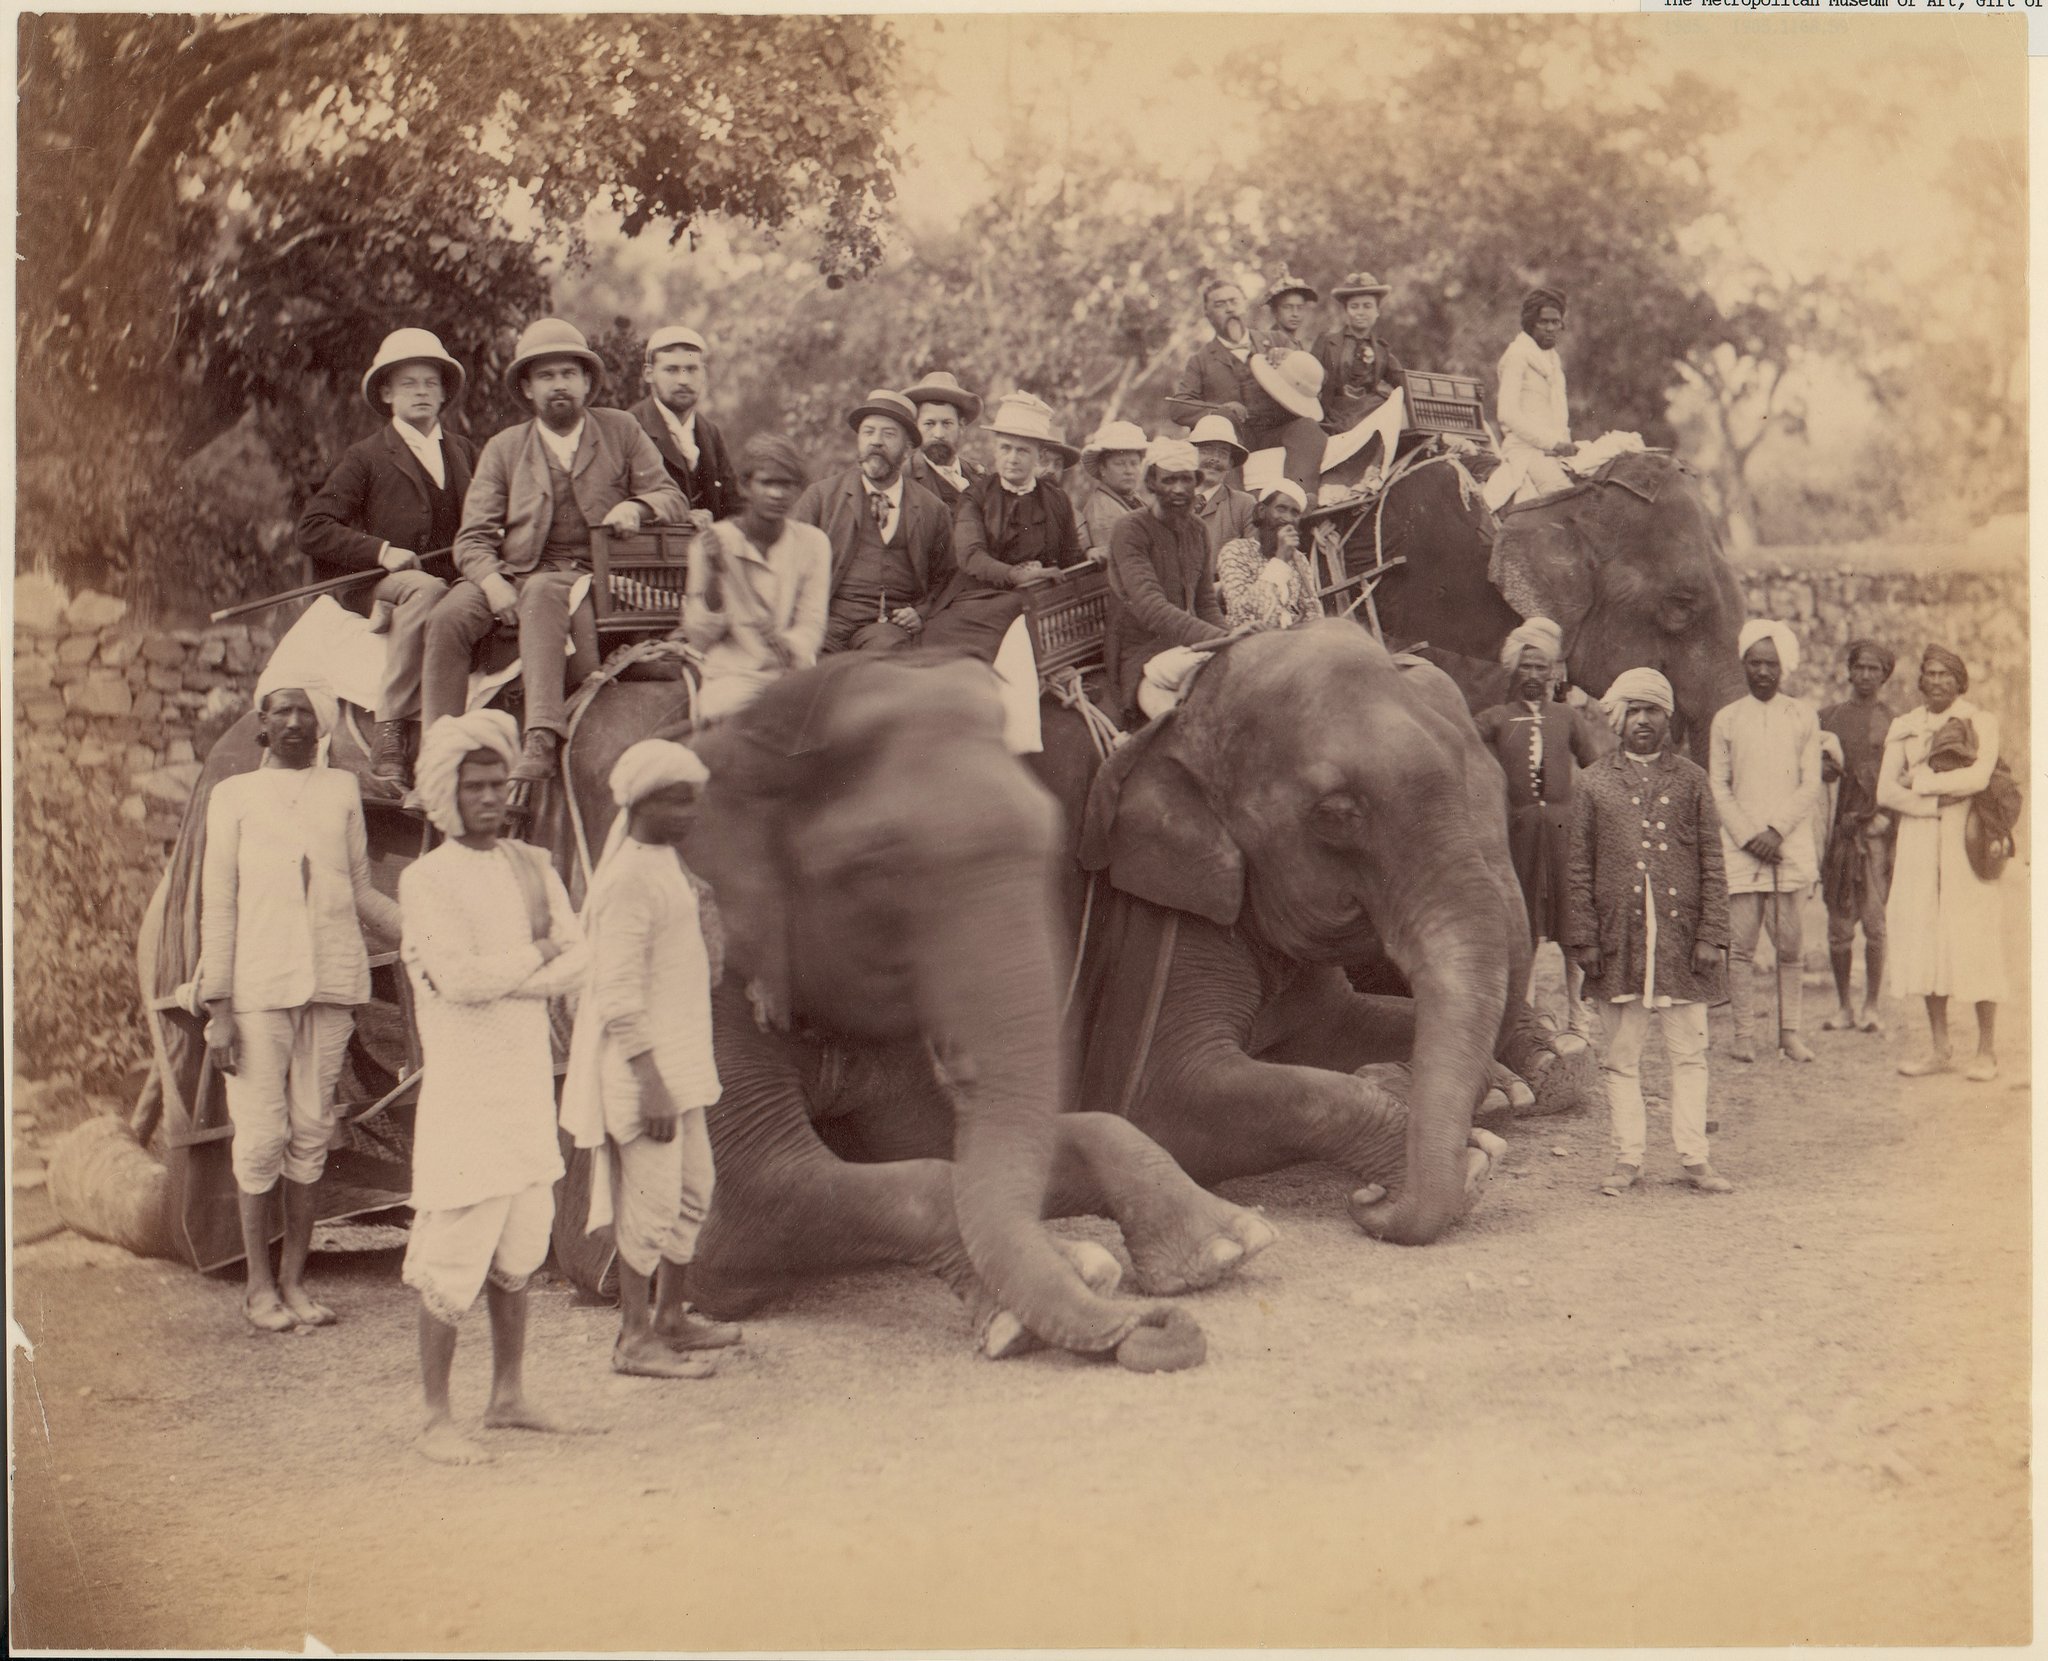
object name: photograph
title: Elephant Group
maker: Anonymous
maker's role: artist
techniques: albumen silver print, glass negative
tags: men,elephants